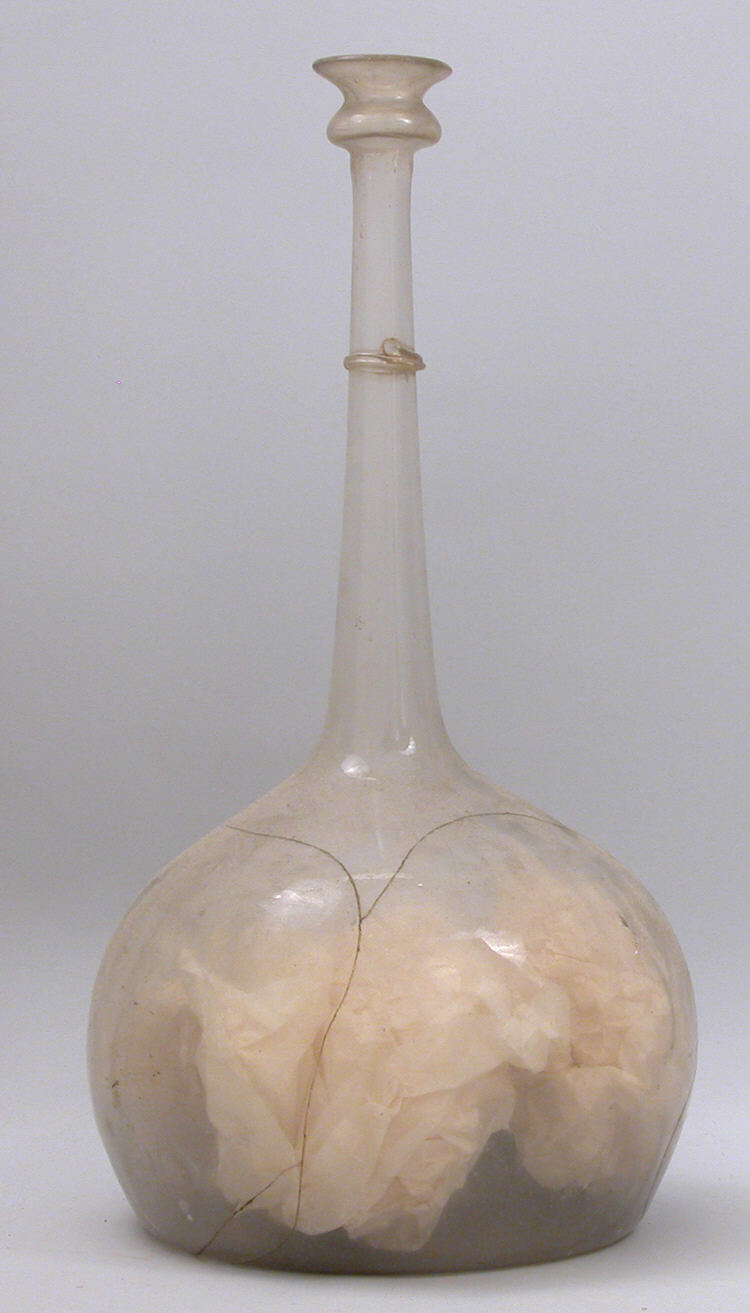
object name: bottle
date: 1701-1900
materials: glass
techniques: glassblowing, tooling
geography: iran